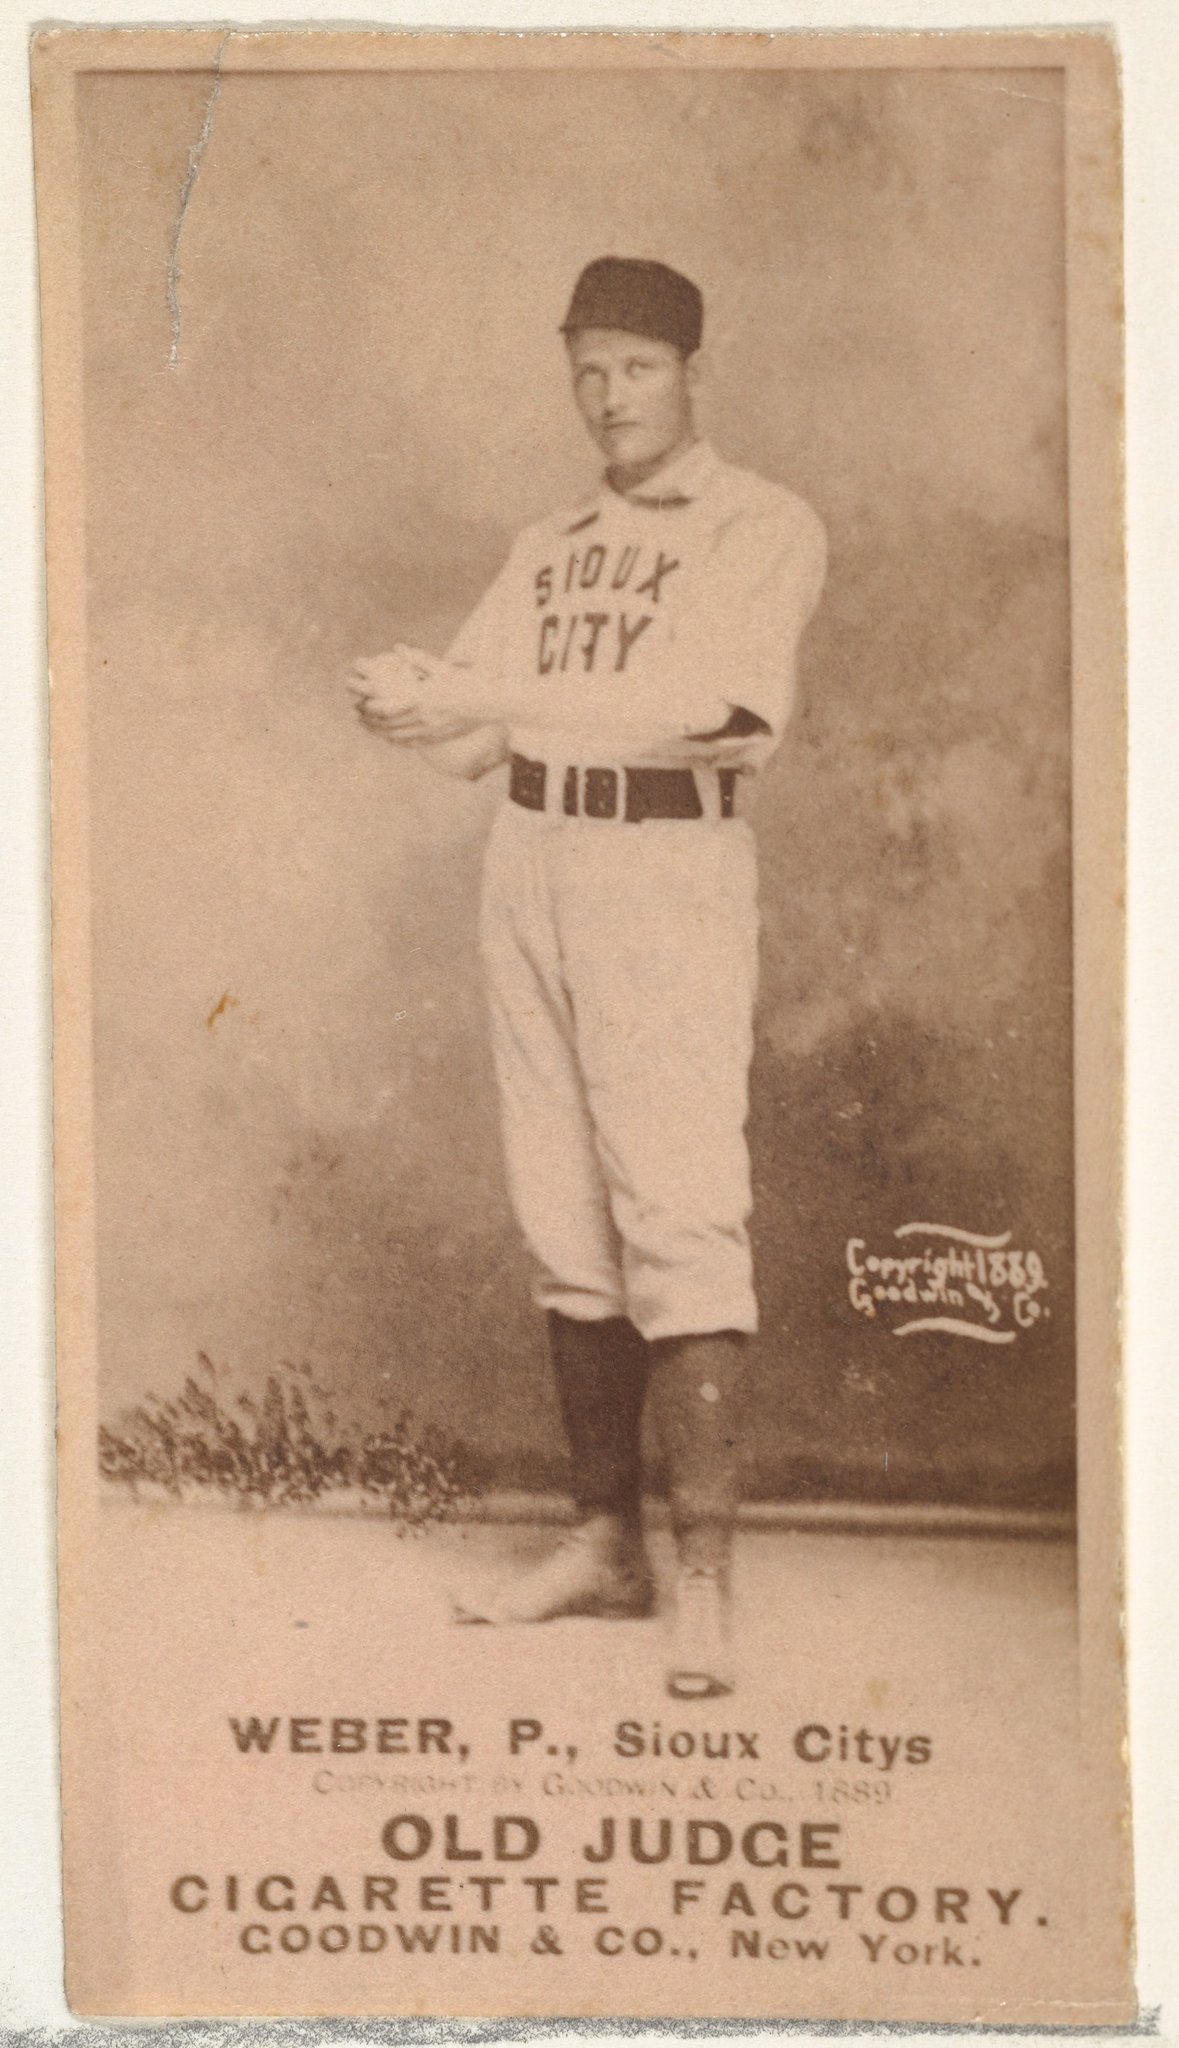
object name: baseball card, photograph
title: Peter W. Webber, Pitcher, Sioux City Corn Huskers, from the Old Judge series (N172) for Old Judge Cigarettes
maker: goodwin & company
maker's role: publisher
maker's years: 1850-1950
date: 1889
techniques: albumen silver print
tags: men,portraits,baseball,athletes